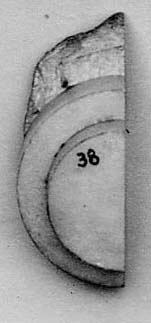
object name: fragment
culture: burmese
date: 1902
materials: jade